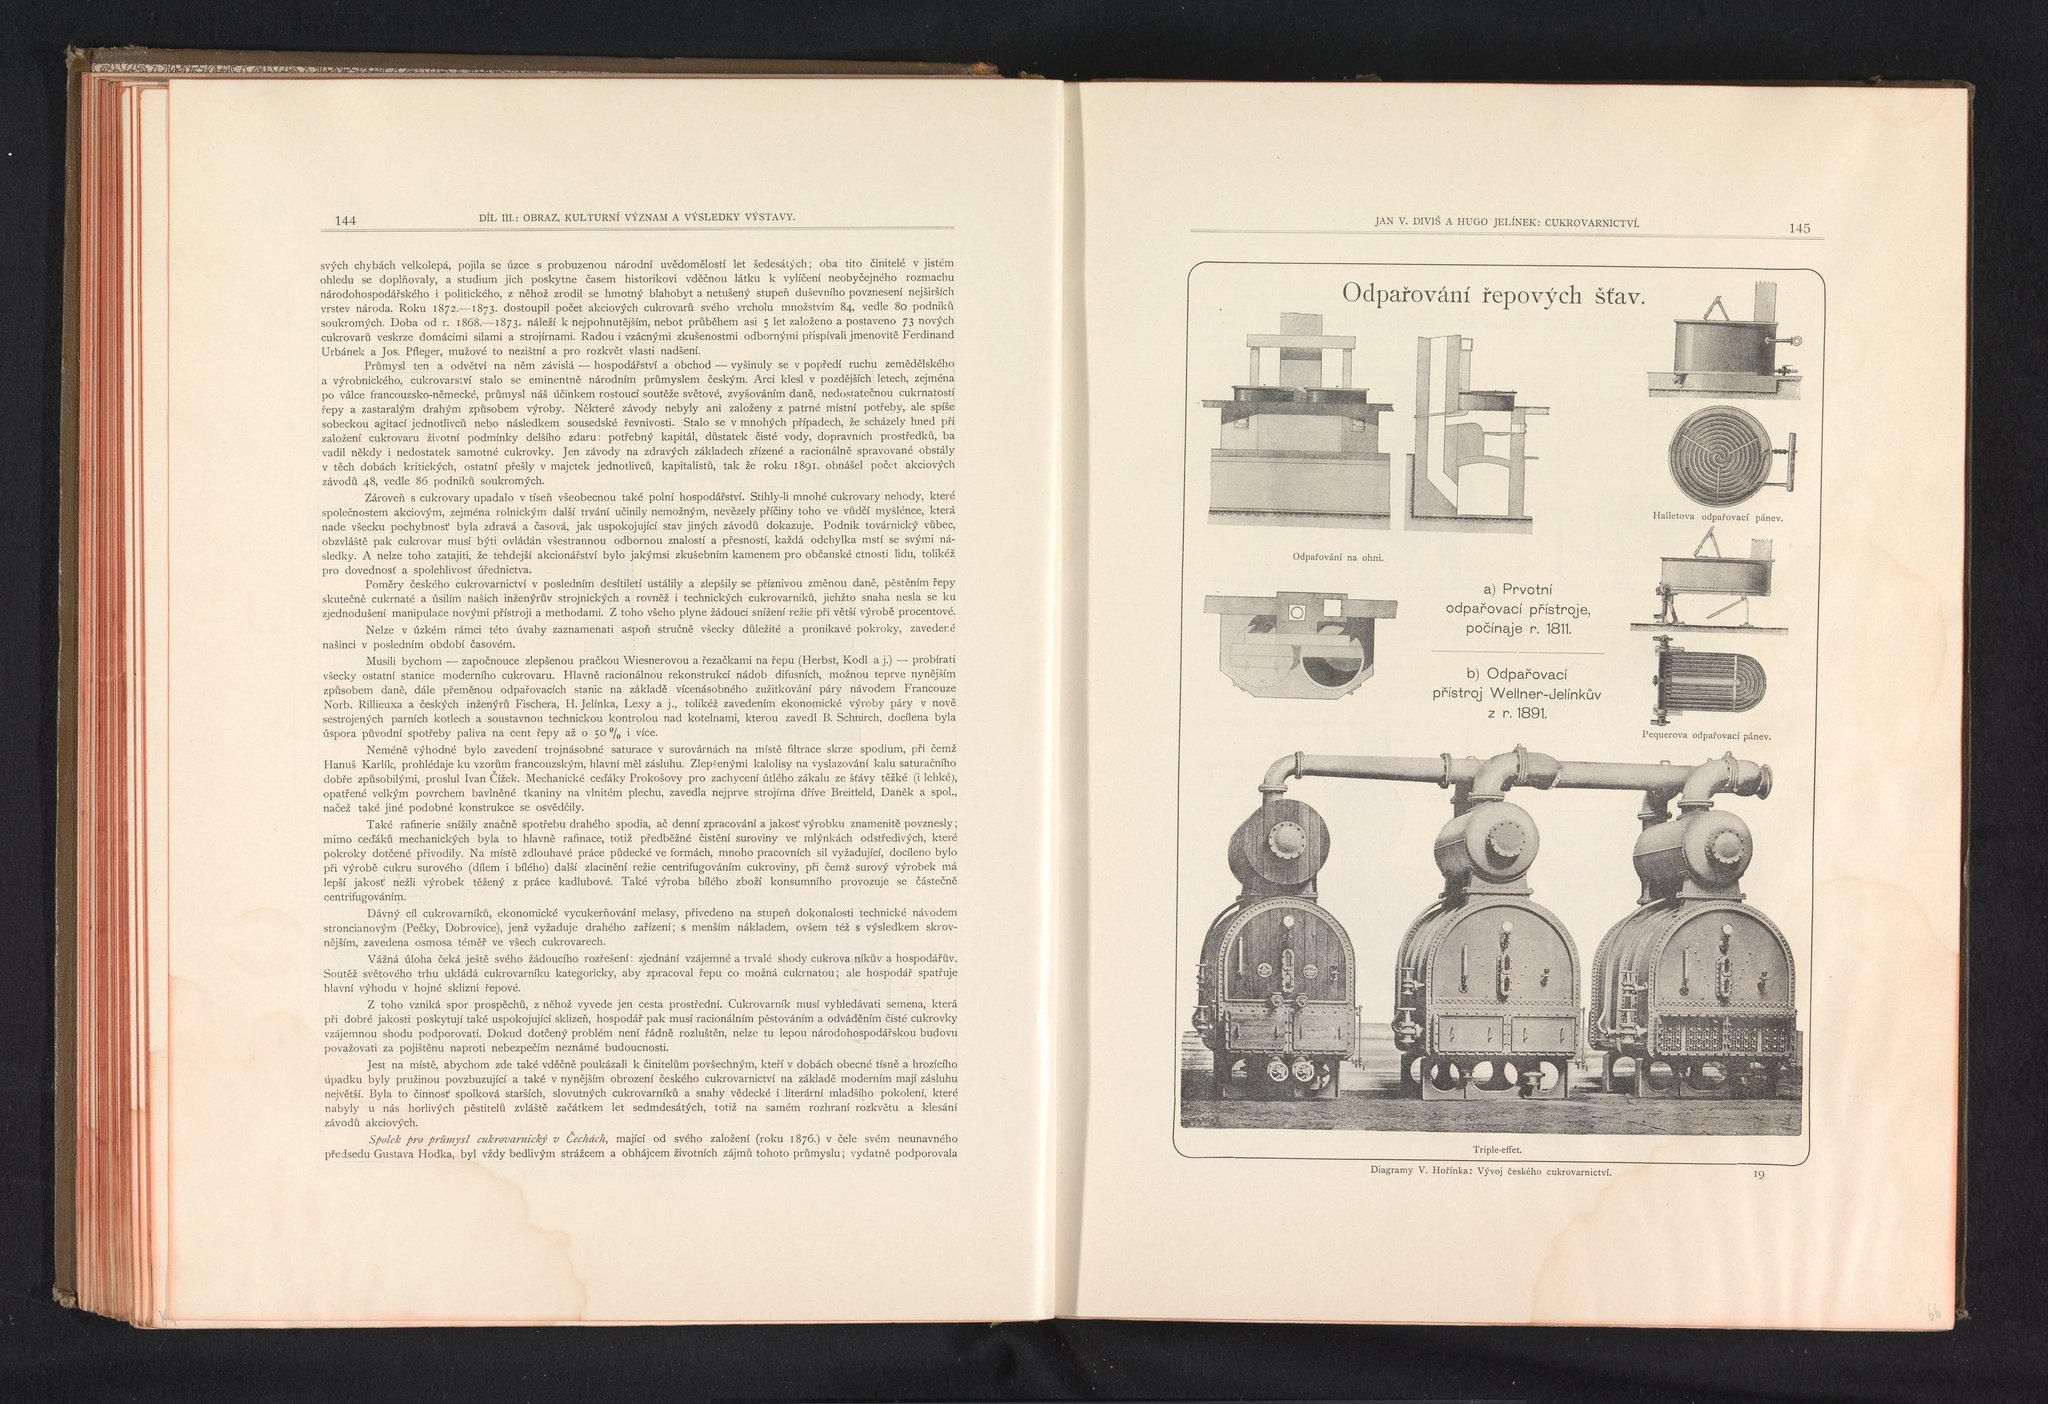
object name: page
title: Odparováni repovych stav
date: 1891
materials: paper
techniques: autotype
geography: prague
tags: machines; parts of machines; tools and appliances